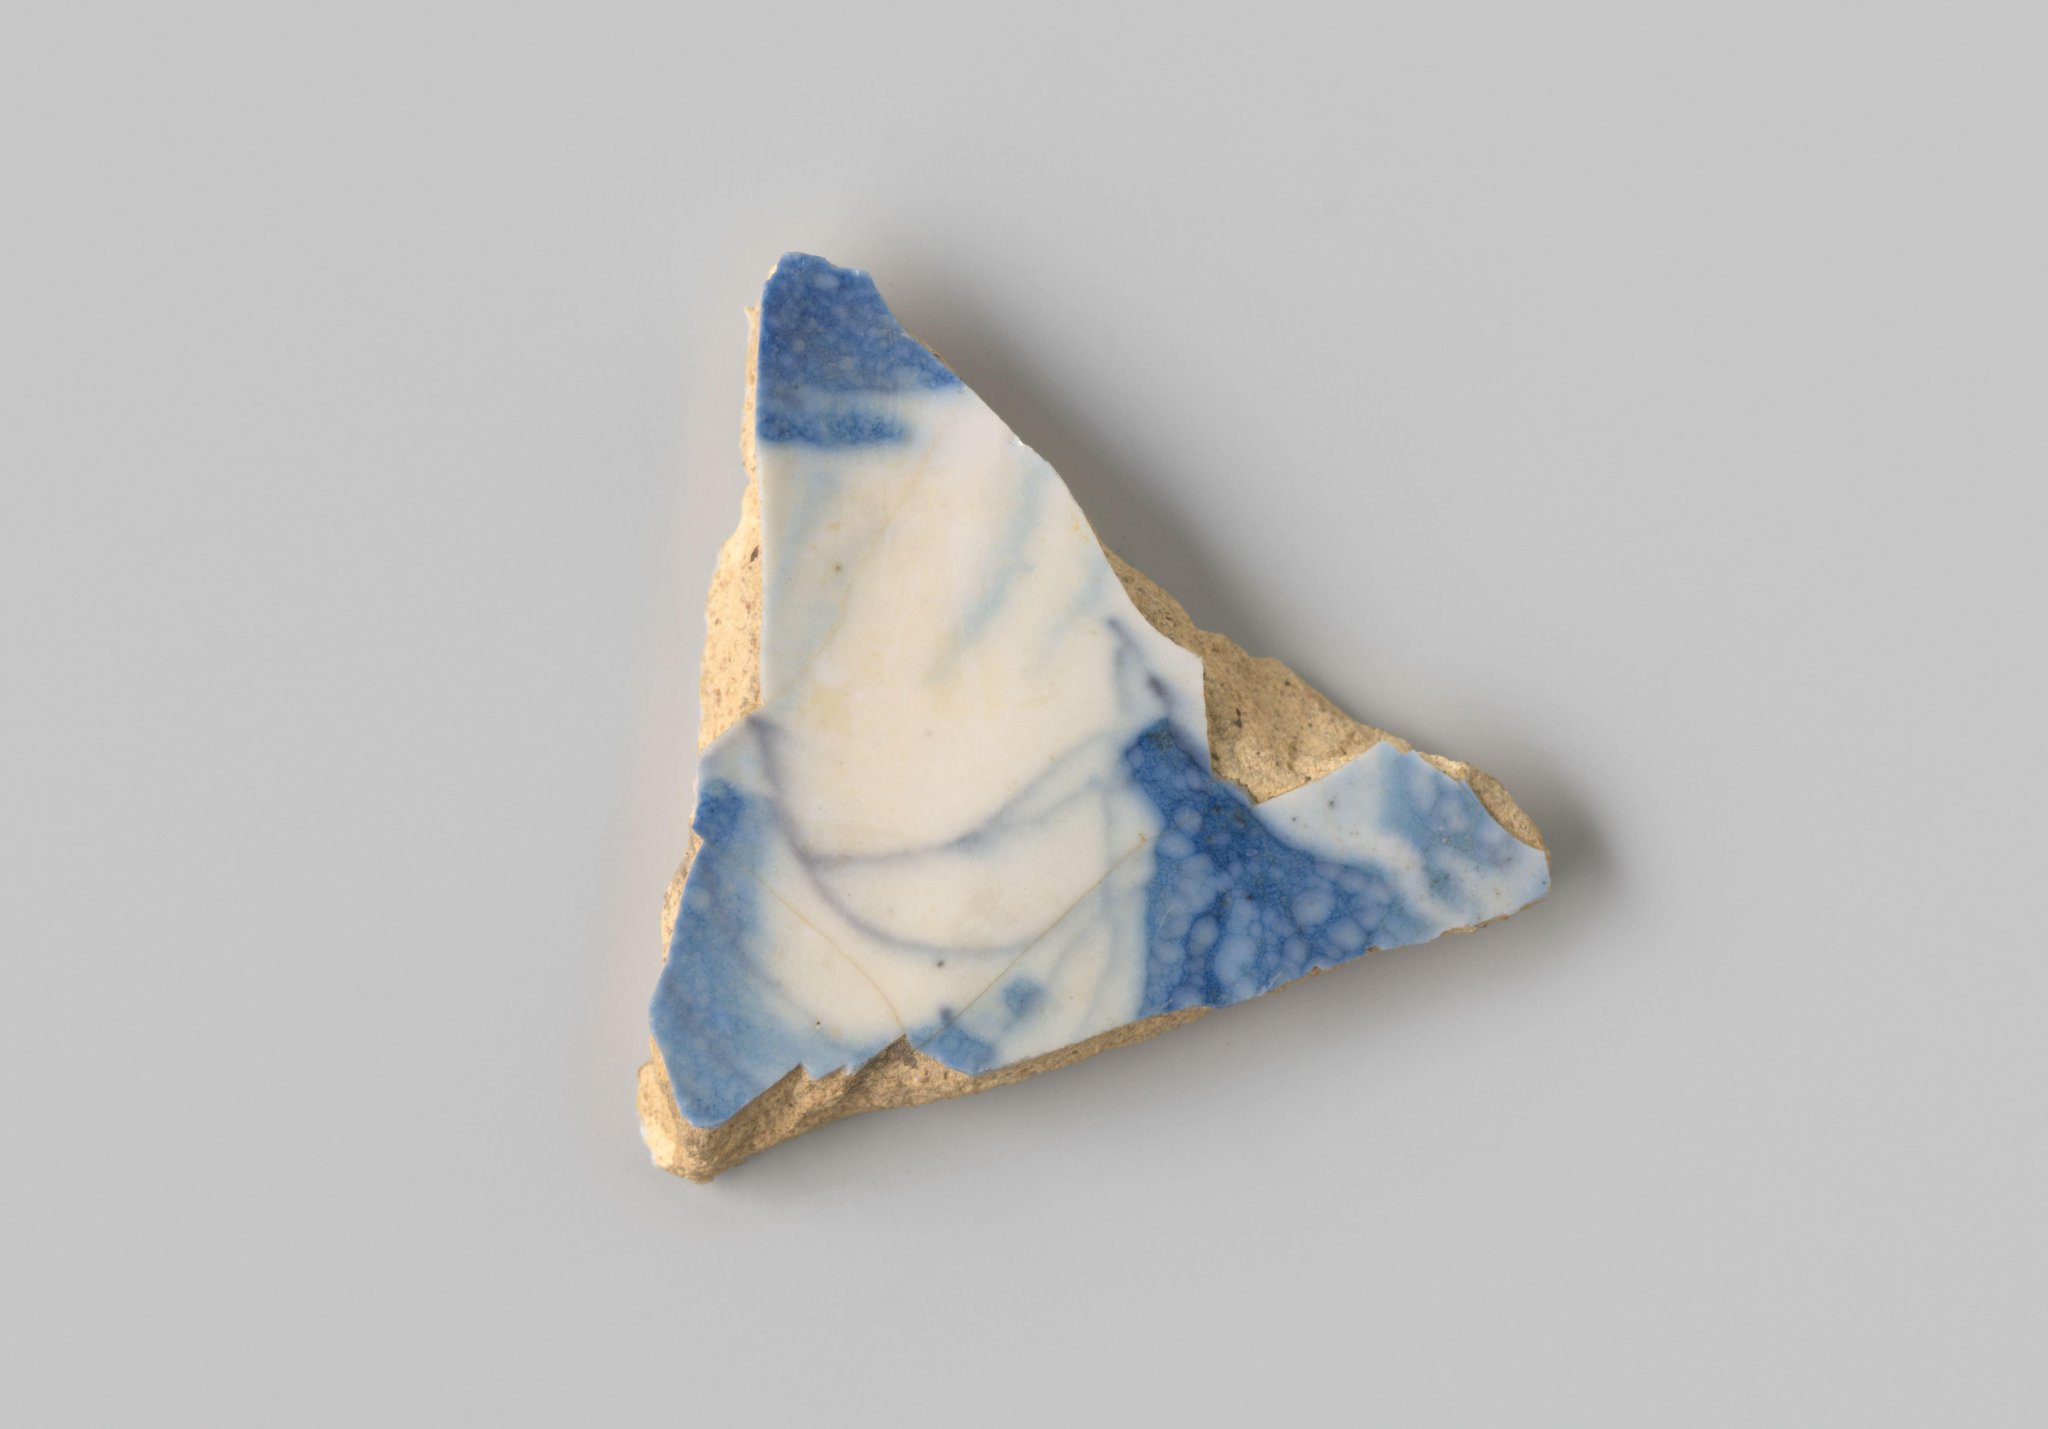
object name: sherd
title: Scherf van witbakkend aardewerk, aan de buitenzijde voorzien van een beschildering in blauw op een witte ondergrond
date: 1500-1899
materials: earthenware, glaze